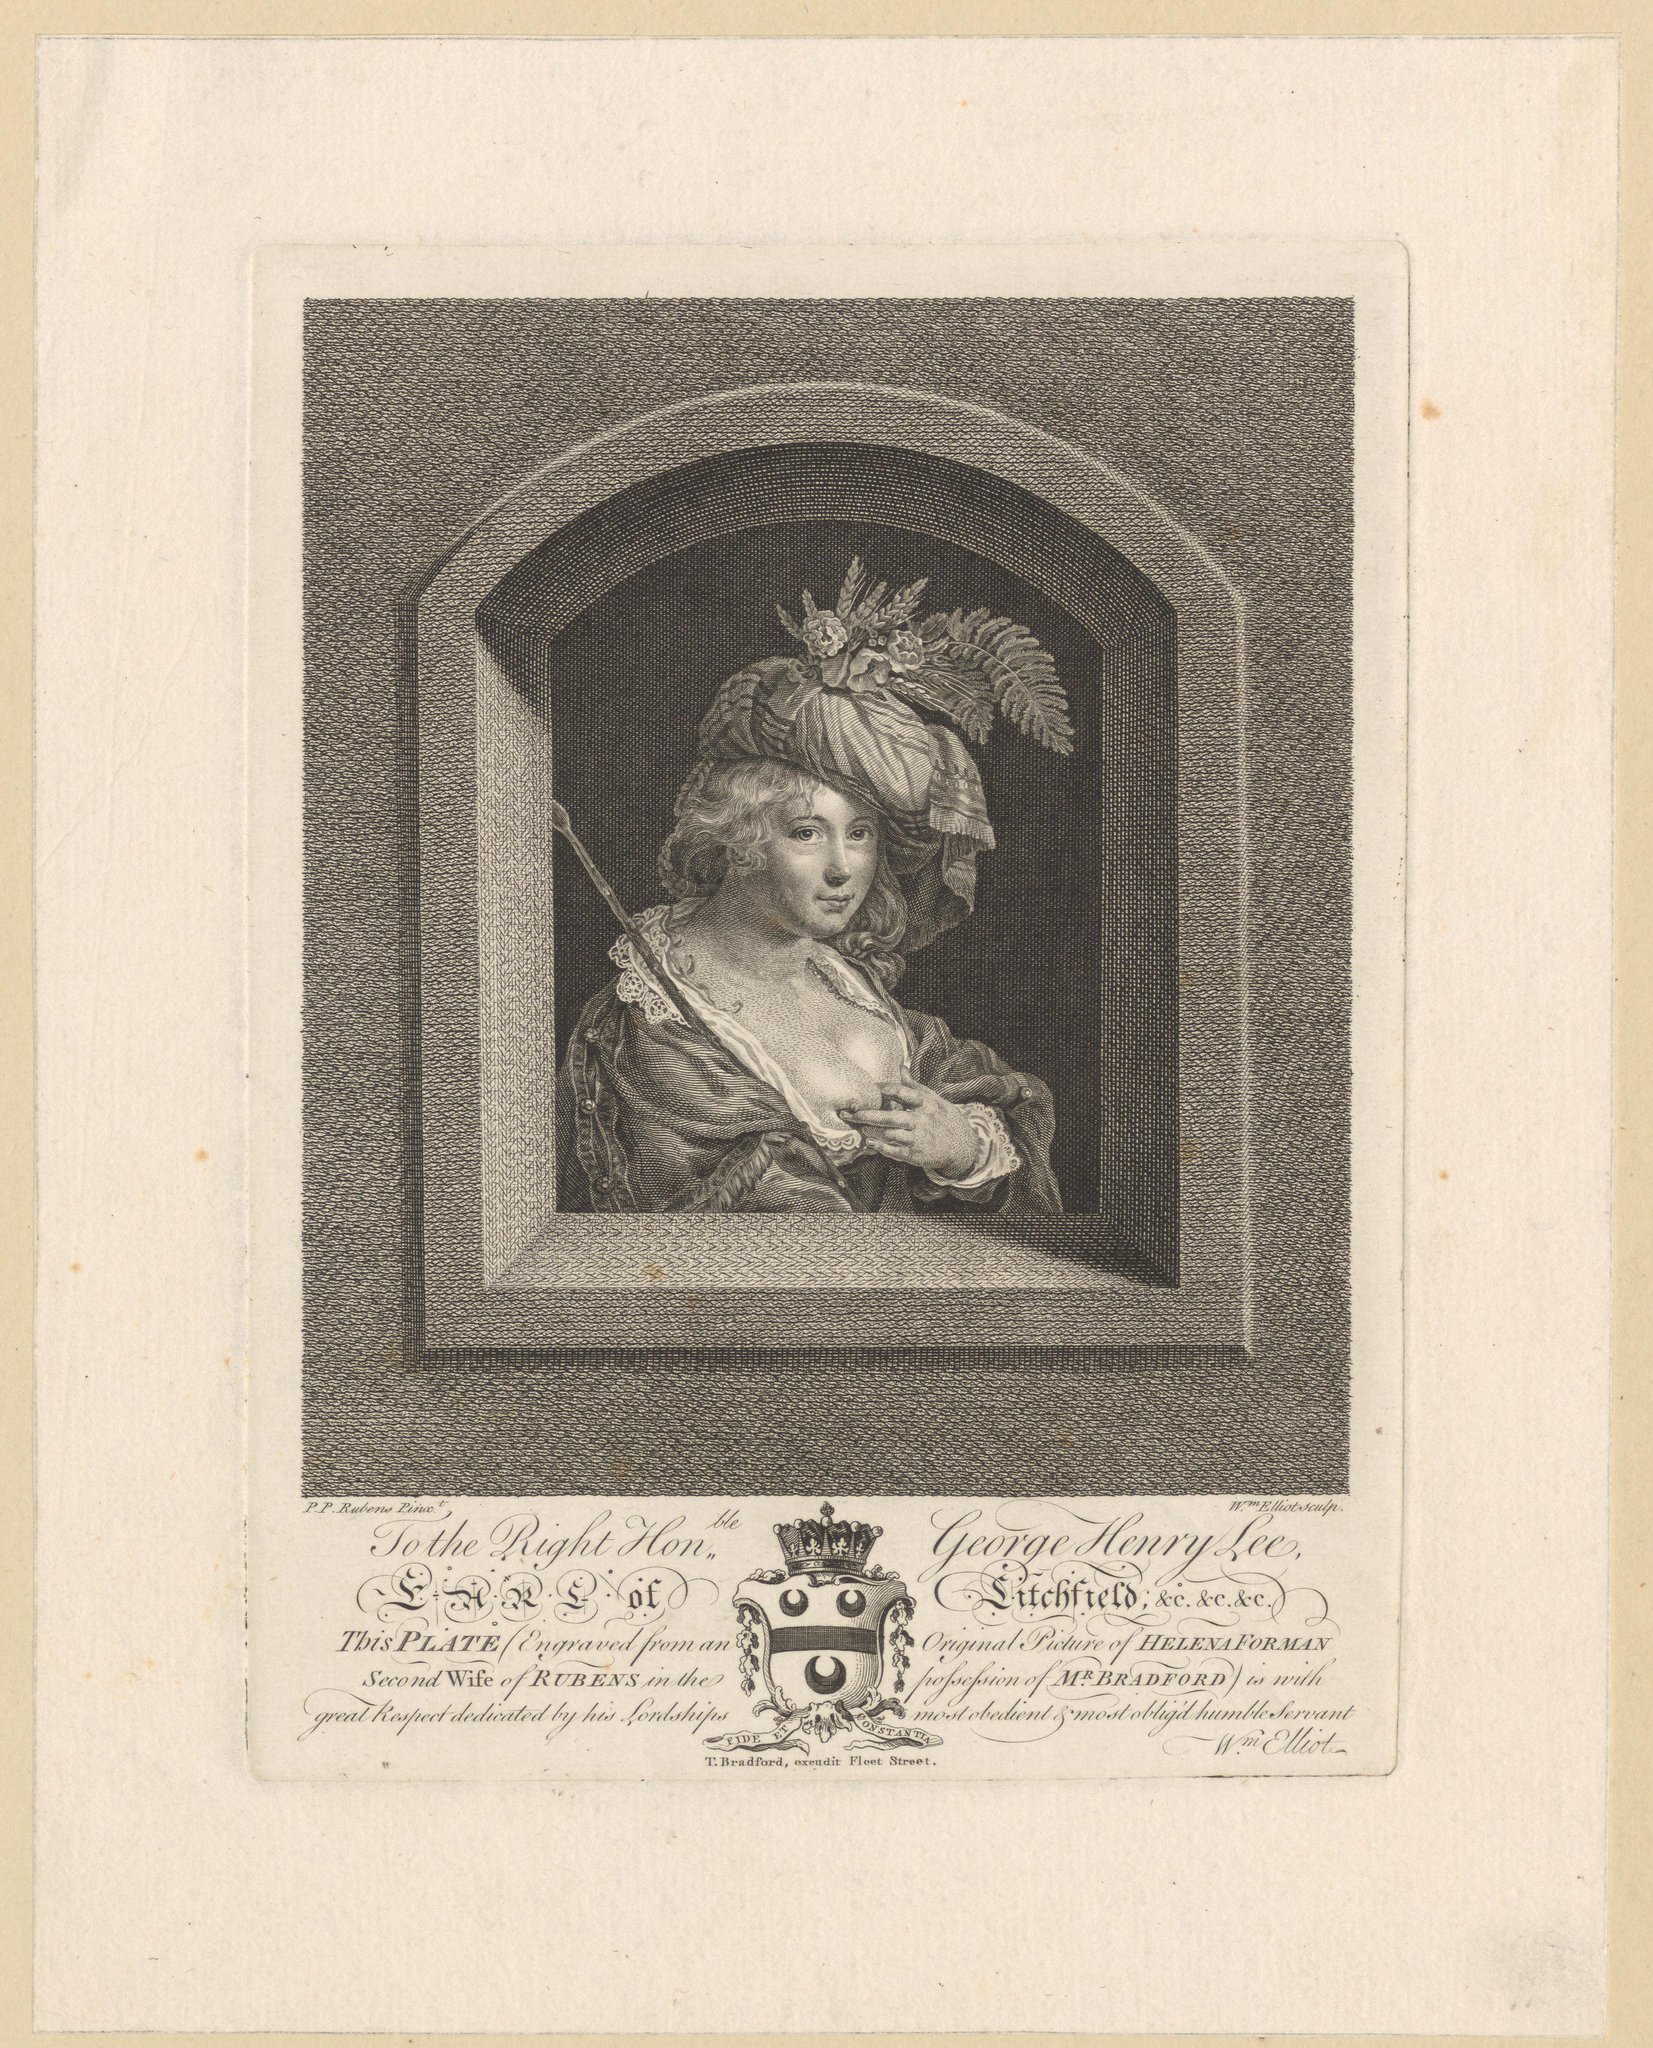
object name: print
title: Portret van Susanna Lunden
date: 1763-1766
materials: paper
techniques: engraving, etching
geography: london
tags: cut flowers; nosegay, bunch of flowers, historical persons - bb - woman, hand holding the breast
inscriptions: collector's mark: Lugt 240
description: Portret is niet, zoals op de prent staat, van Helena Fourment, maar van haar zus Susanna Lunden.